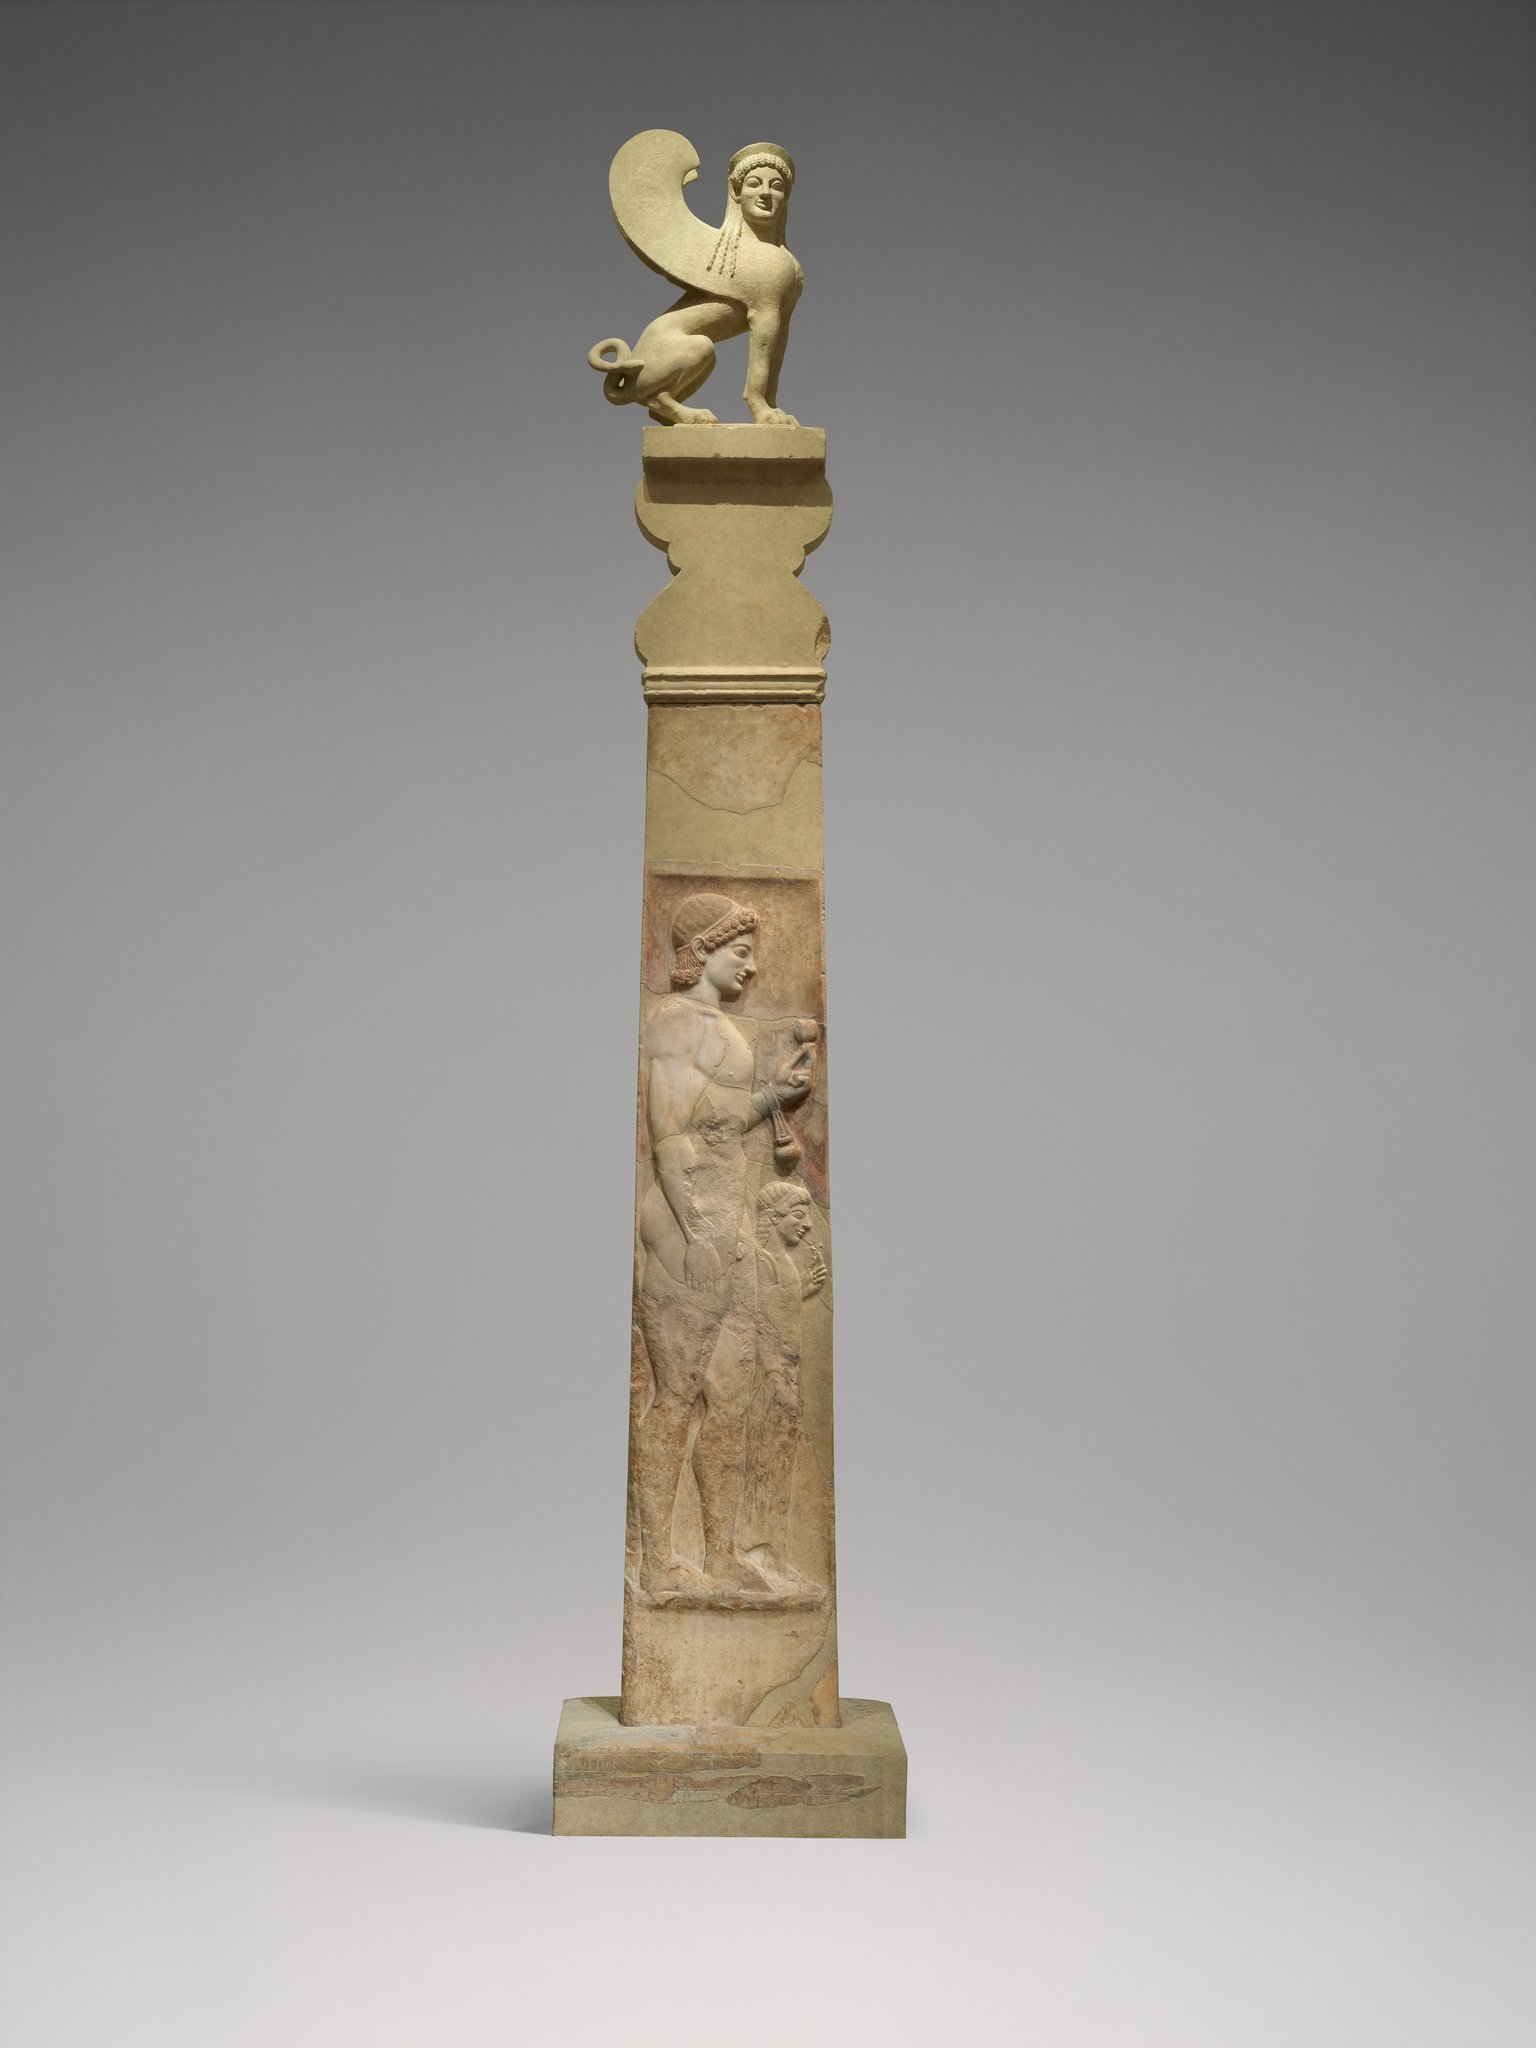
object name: grave stele with a youth and little girl, and a finial in the form of a sphinx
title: Marble stele (grave marker) with a youth and little girl, and a capital and finial in the form of a sphinx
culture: greek, attic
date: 530 BCE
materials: marble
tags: girls,men,sphinx